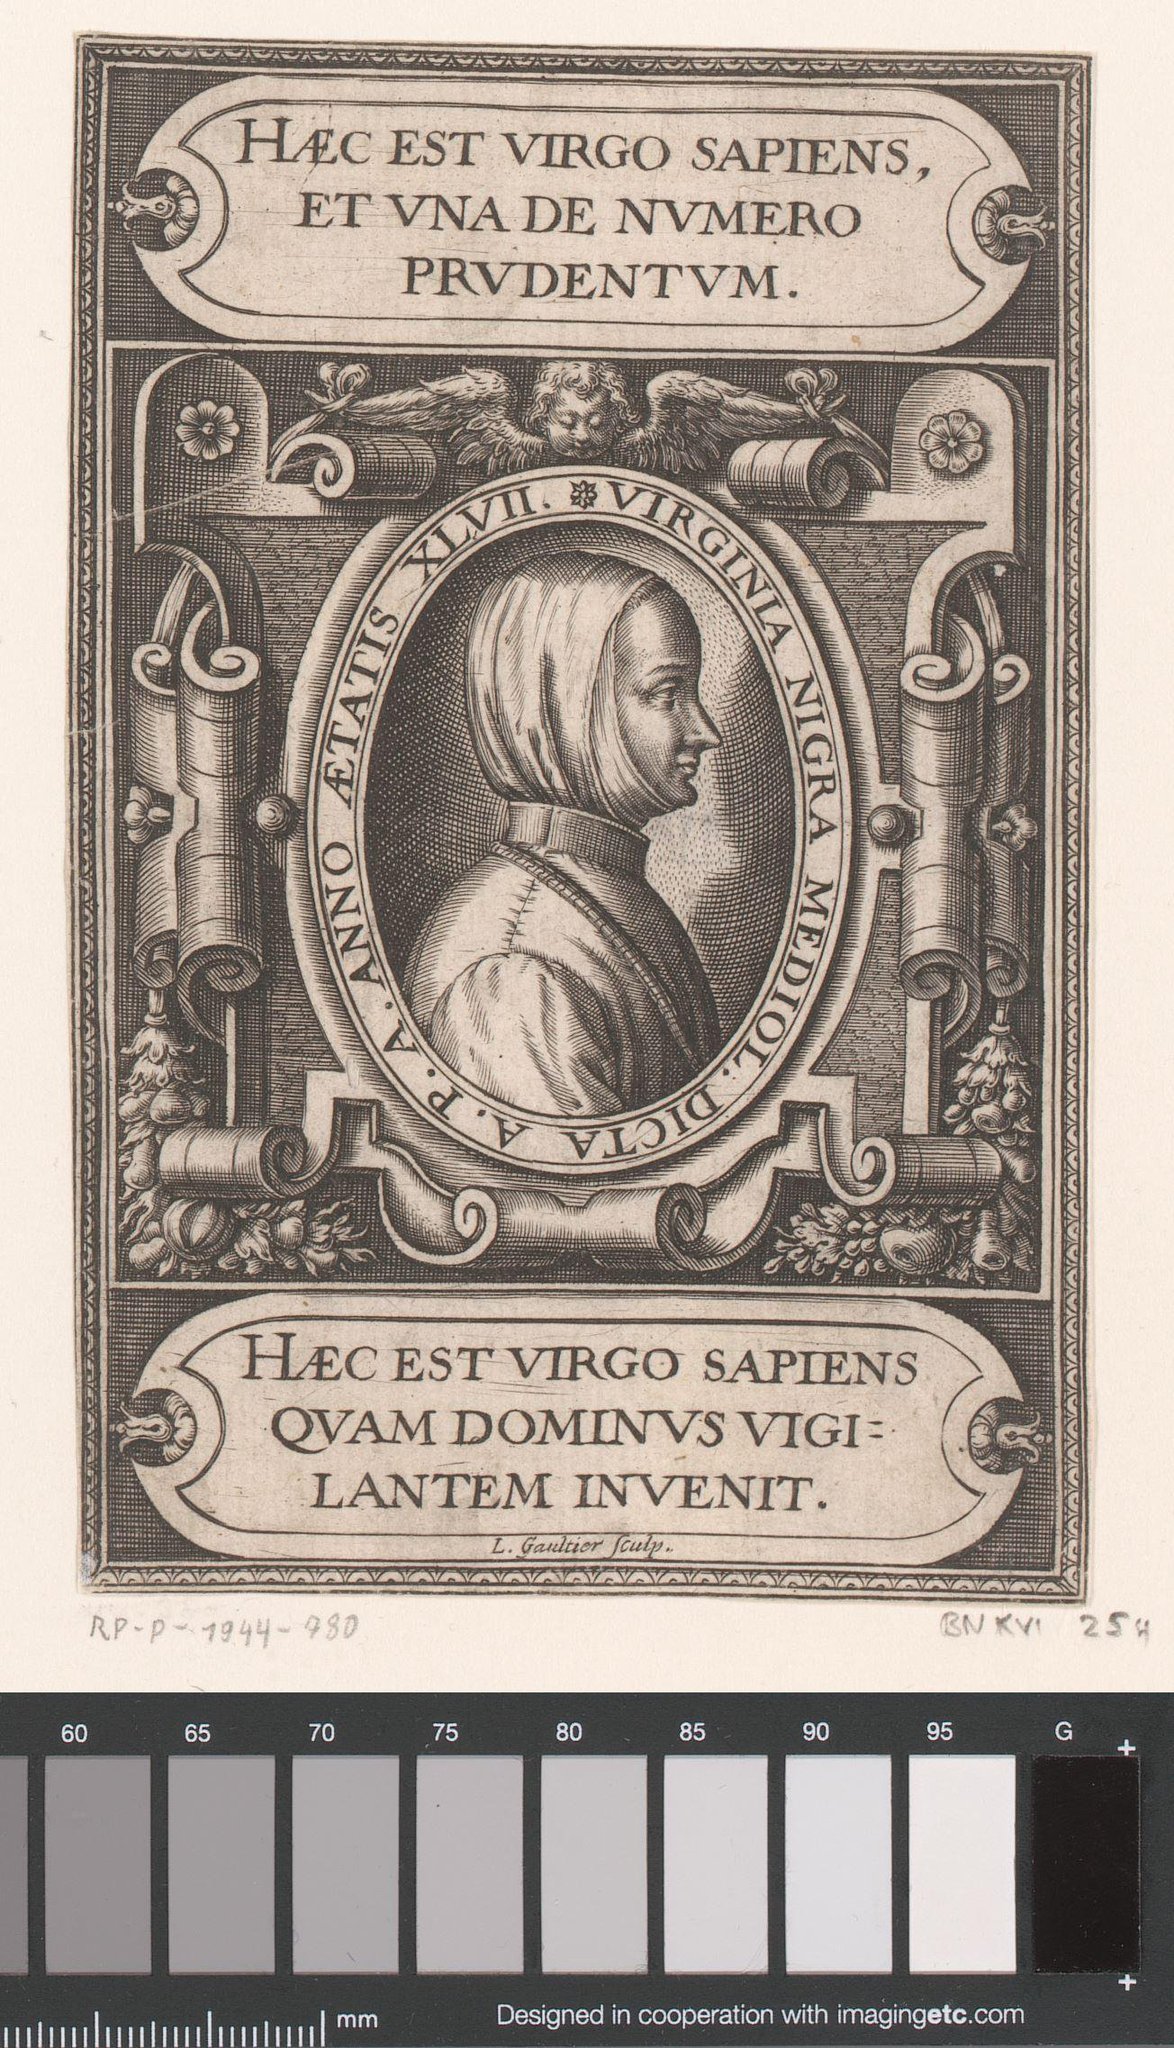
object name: print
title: Portret van Virginia Nigra op 47-jarige leeftijd als wijze maagd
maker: leonard gaultier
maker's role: print maker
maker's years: 1561-1641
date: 1590-1620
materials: paper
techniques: engraving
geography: france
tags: historical persons - bb - woman, ornament ~ medallion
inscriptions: collector's mark: Lugt 2228